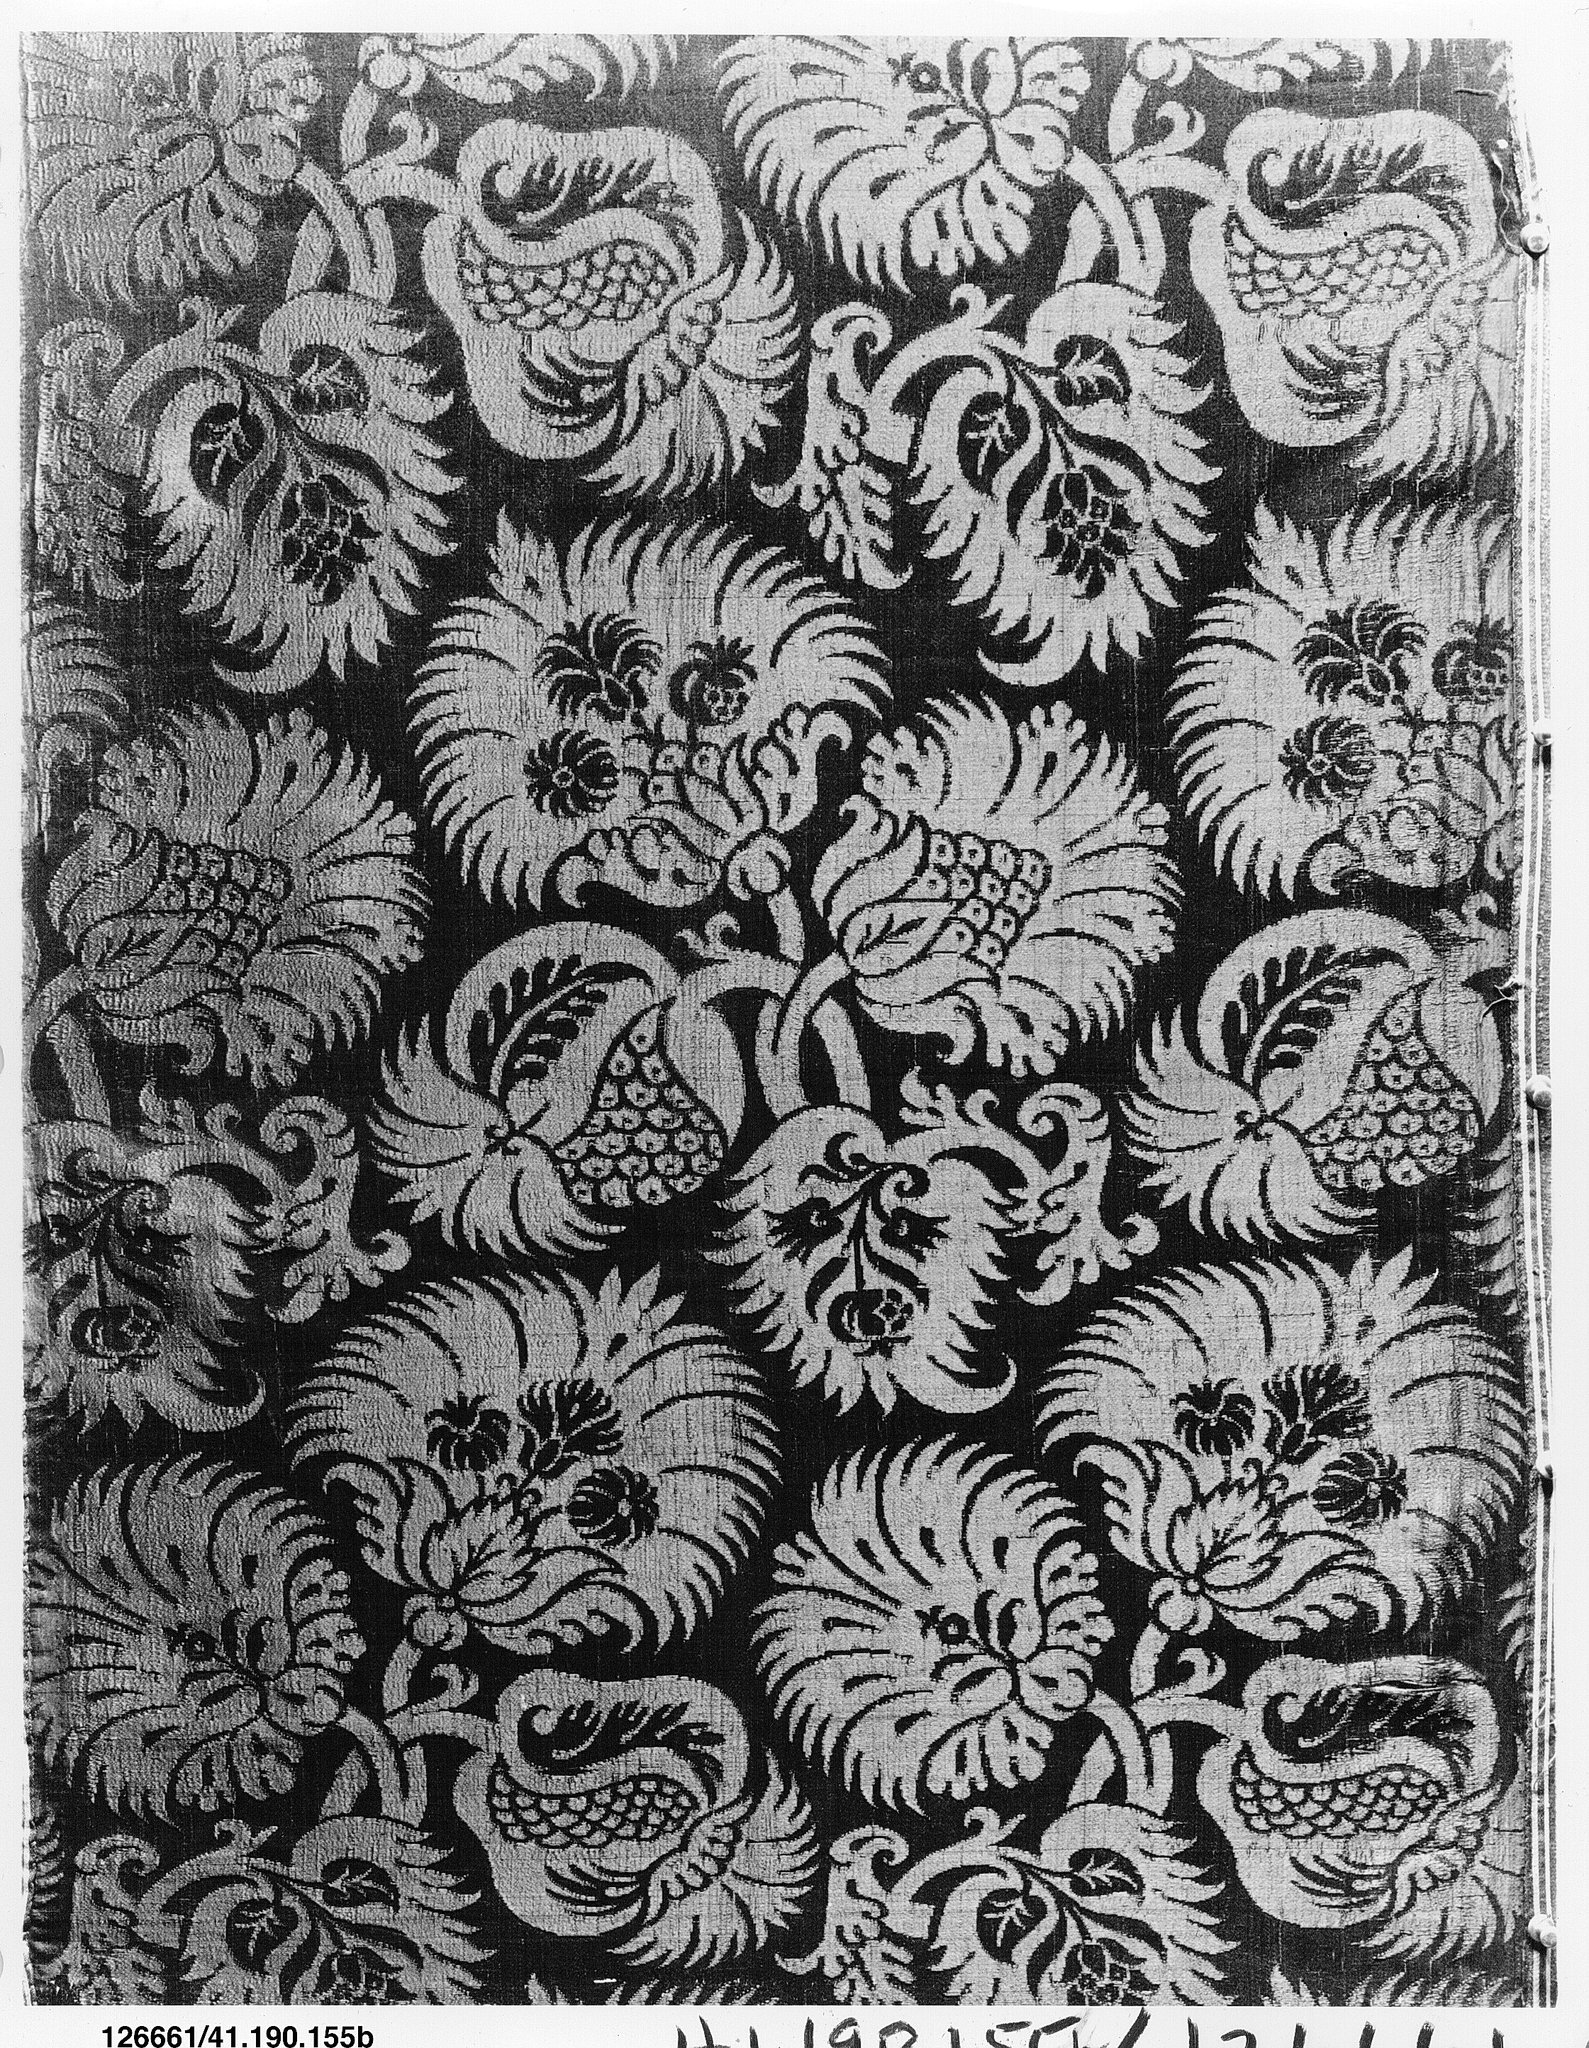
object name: piece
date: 1625-1635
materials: silk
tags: flowers